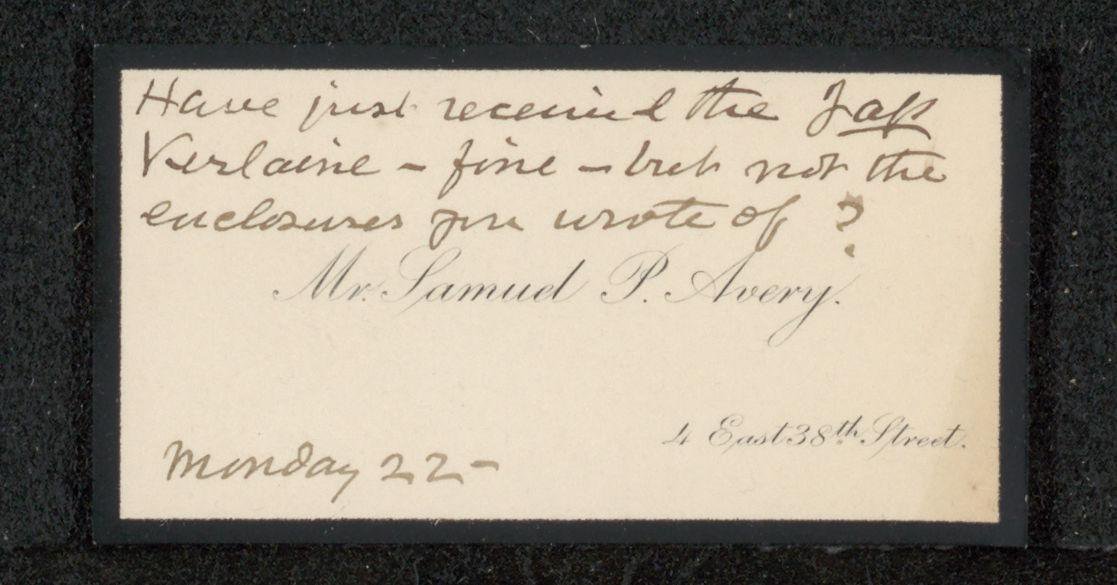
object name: visiting card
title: Visitekaartje uit archief Philip Zilcken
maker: samuel putnam avery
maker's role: verzamelaar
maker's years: 1822-1904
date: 1832-1904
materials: cardboard, ink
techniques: pen, printing, writing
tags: paris, paul verlaine, the hague, painter, draughtsman, philip zilcken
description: Visitekaartje werd oorspronkelijk bewaard bij een groep krantenknipsels behorend tot correspondentie van Samuel Putnam Avery aan Philip Zilcken, zie RP-D-1982-43-AVERY-DOC.22.